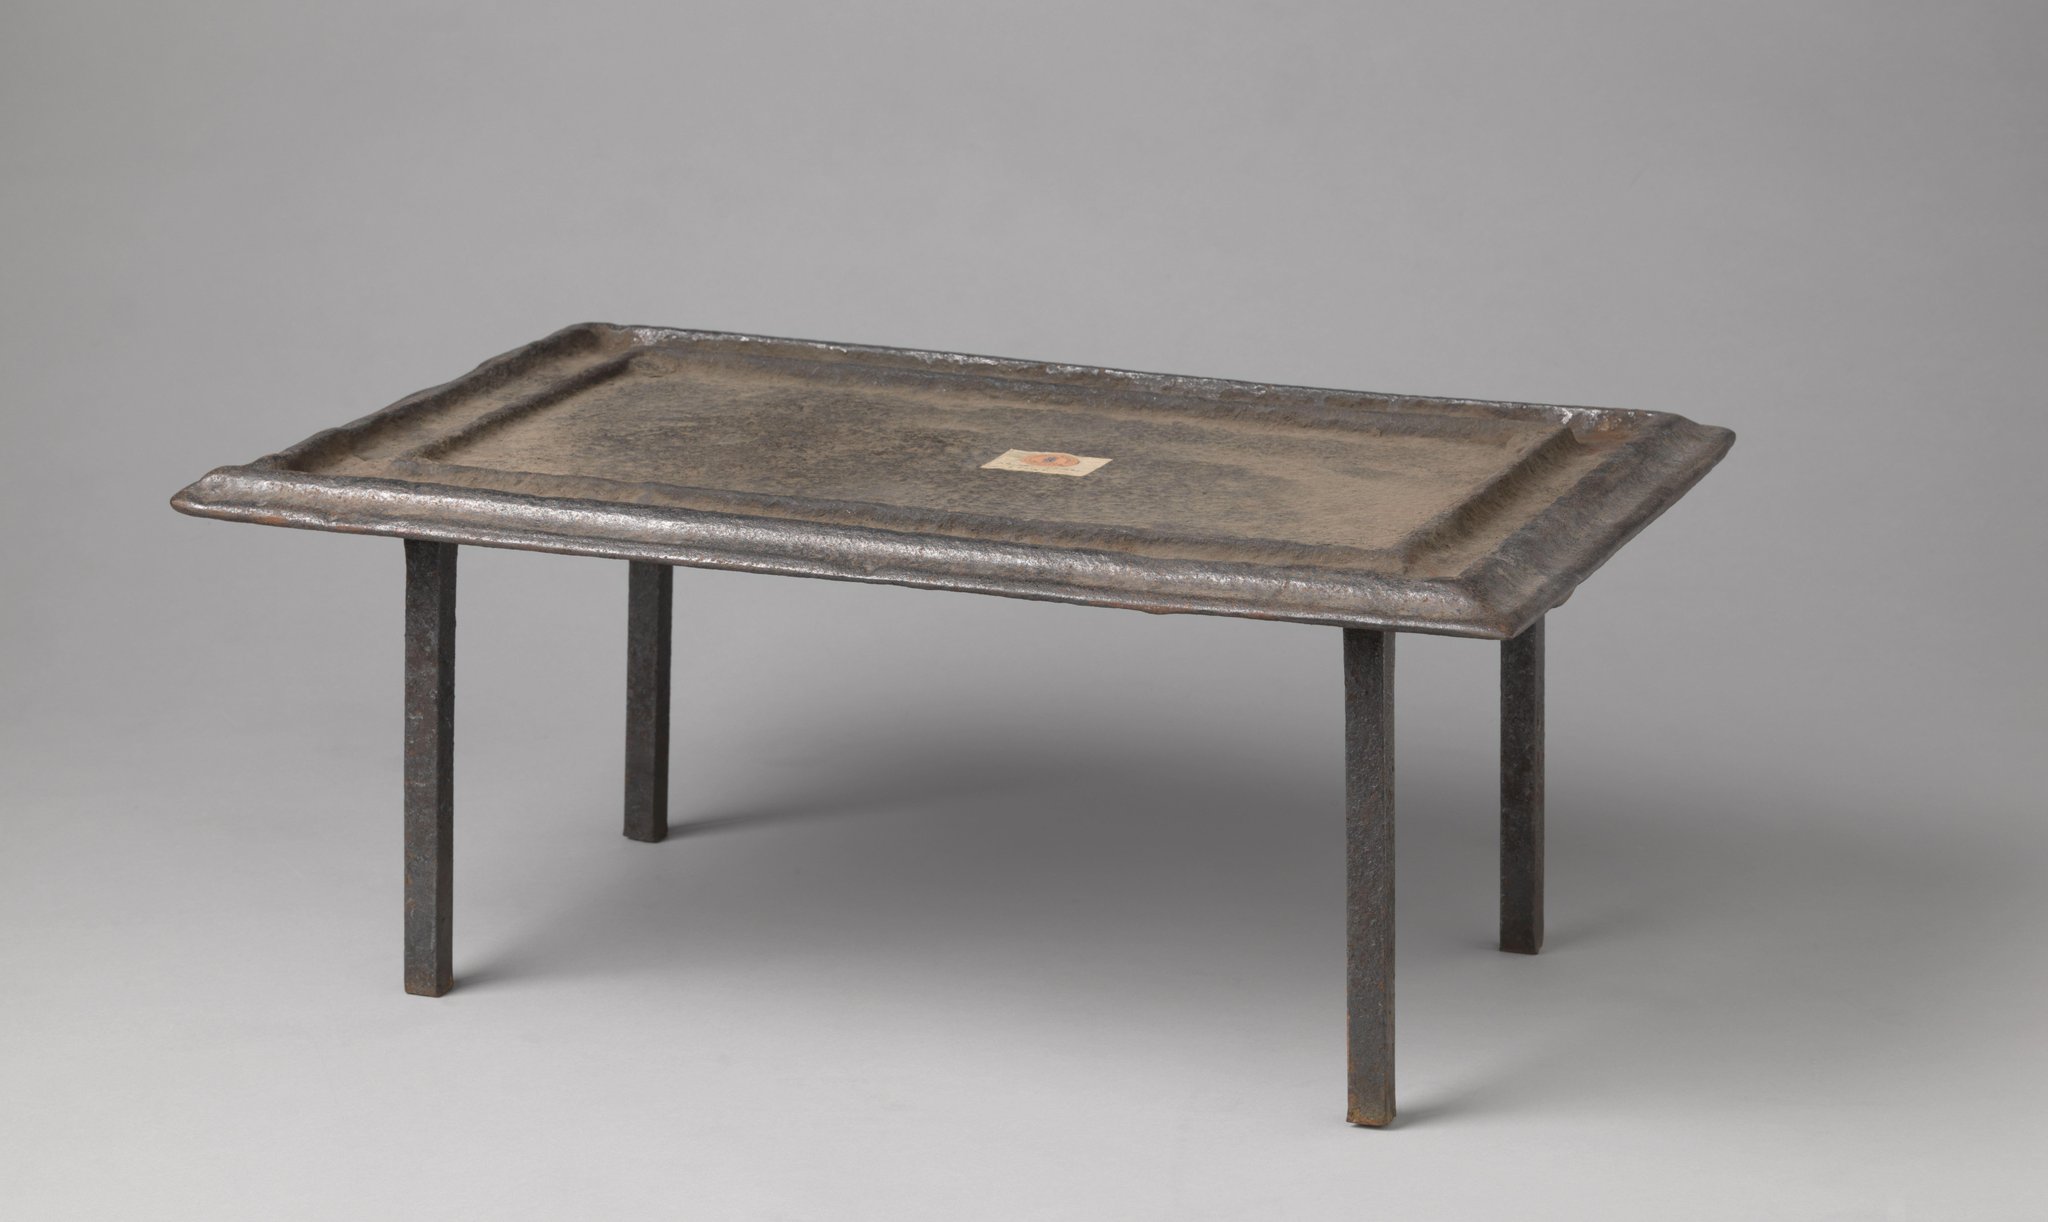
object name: stove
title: Bodemplaat van een kachel op vier poten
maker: Anonymous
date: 1660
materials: iron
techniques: casting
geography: germany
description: Gietijzeren bodemplaat met vier poten, van een kachel. De bovenzijde is voorzien van een dubbele opstaande rand, waarin de zijplaten van de kachel kunnen rusten.